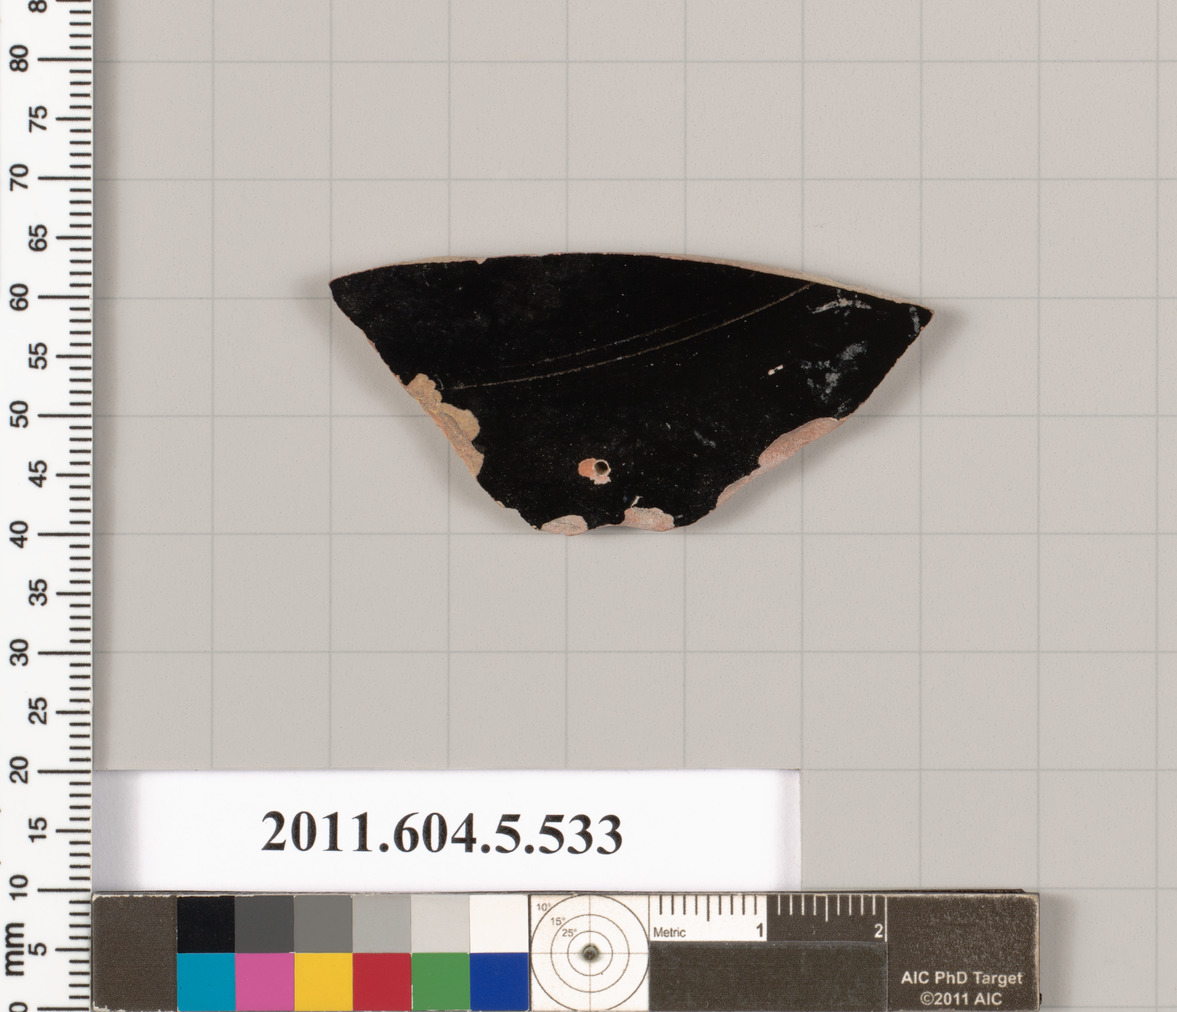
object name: kylix fragment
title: Terracotta fragment of a kylix (drinking cup)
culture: greek, attic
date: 600-401 BCE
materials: terracotta